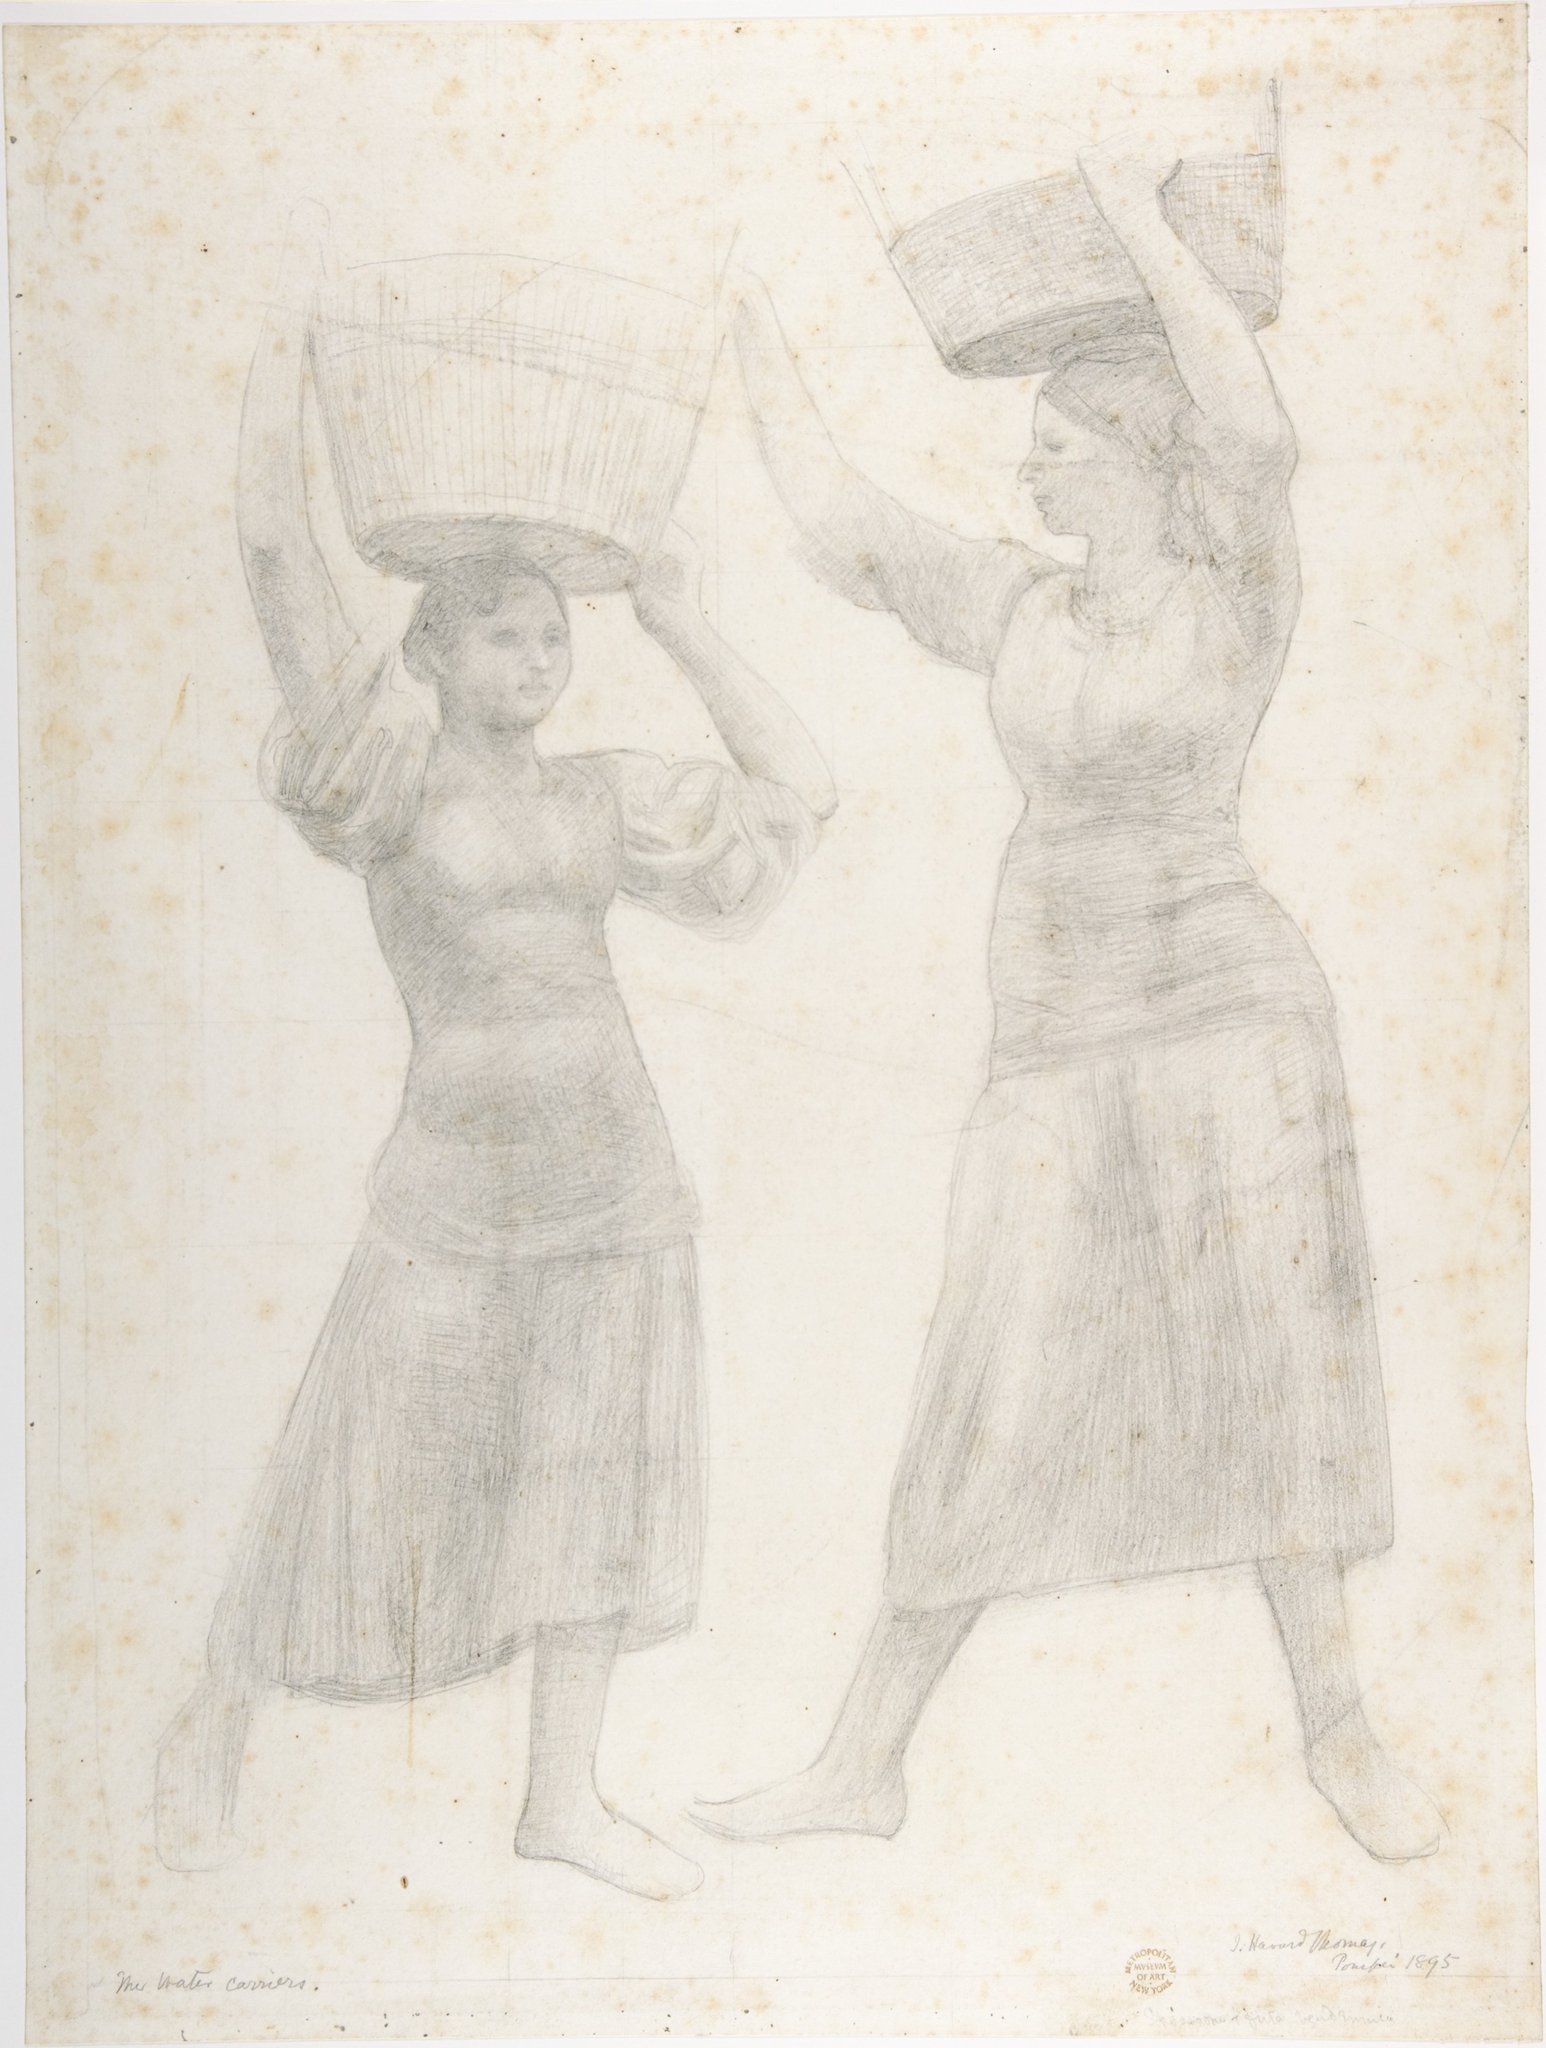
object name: drawing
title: The Water Carriers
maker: james harvard thomas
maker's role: artist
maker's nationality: british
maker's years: 1854-1921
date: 1895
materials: graphite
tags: women